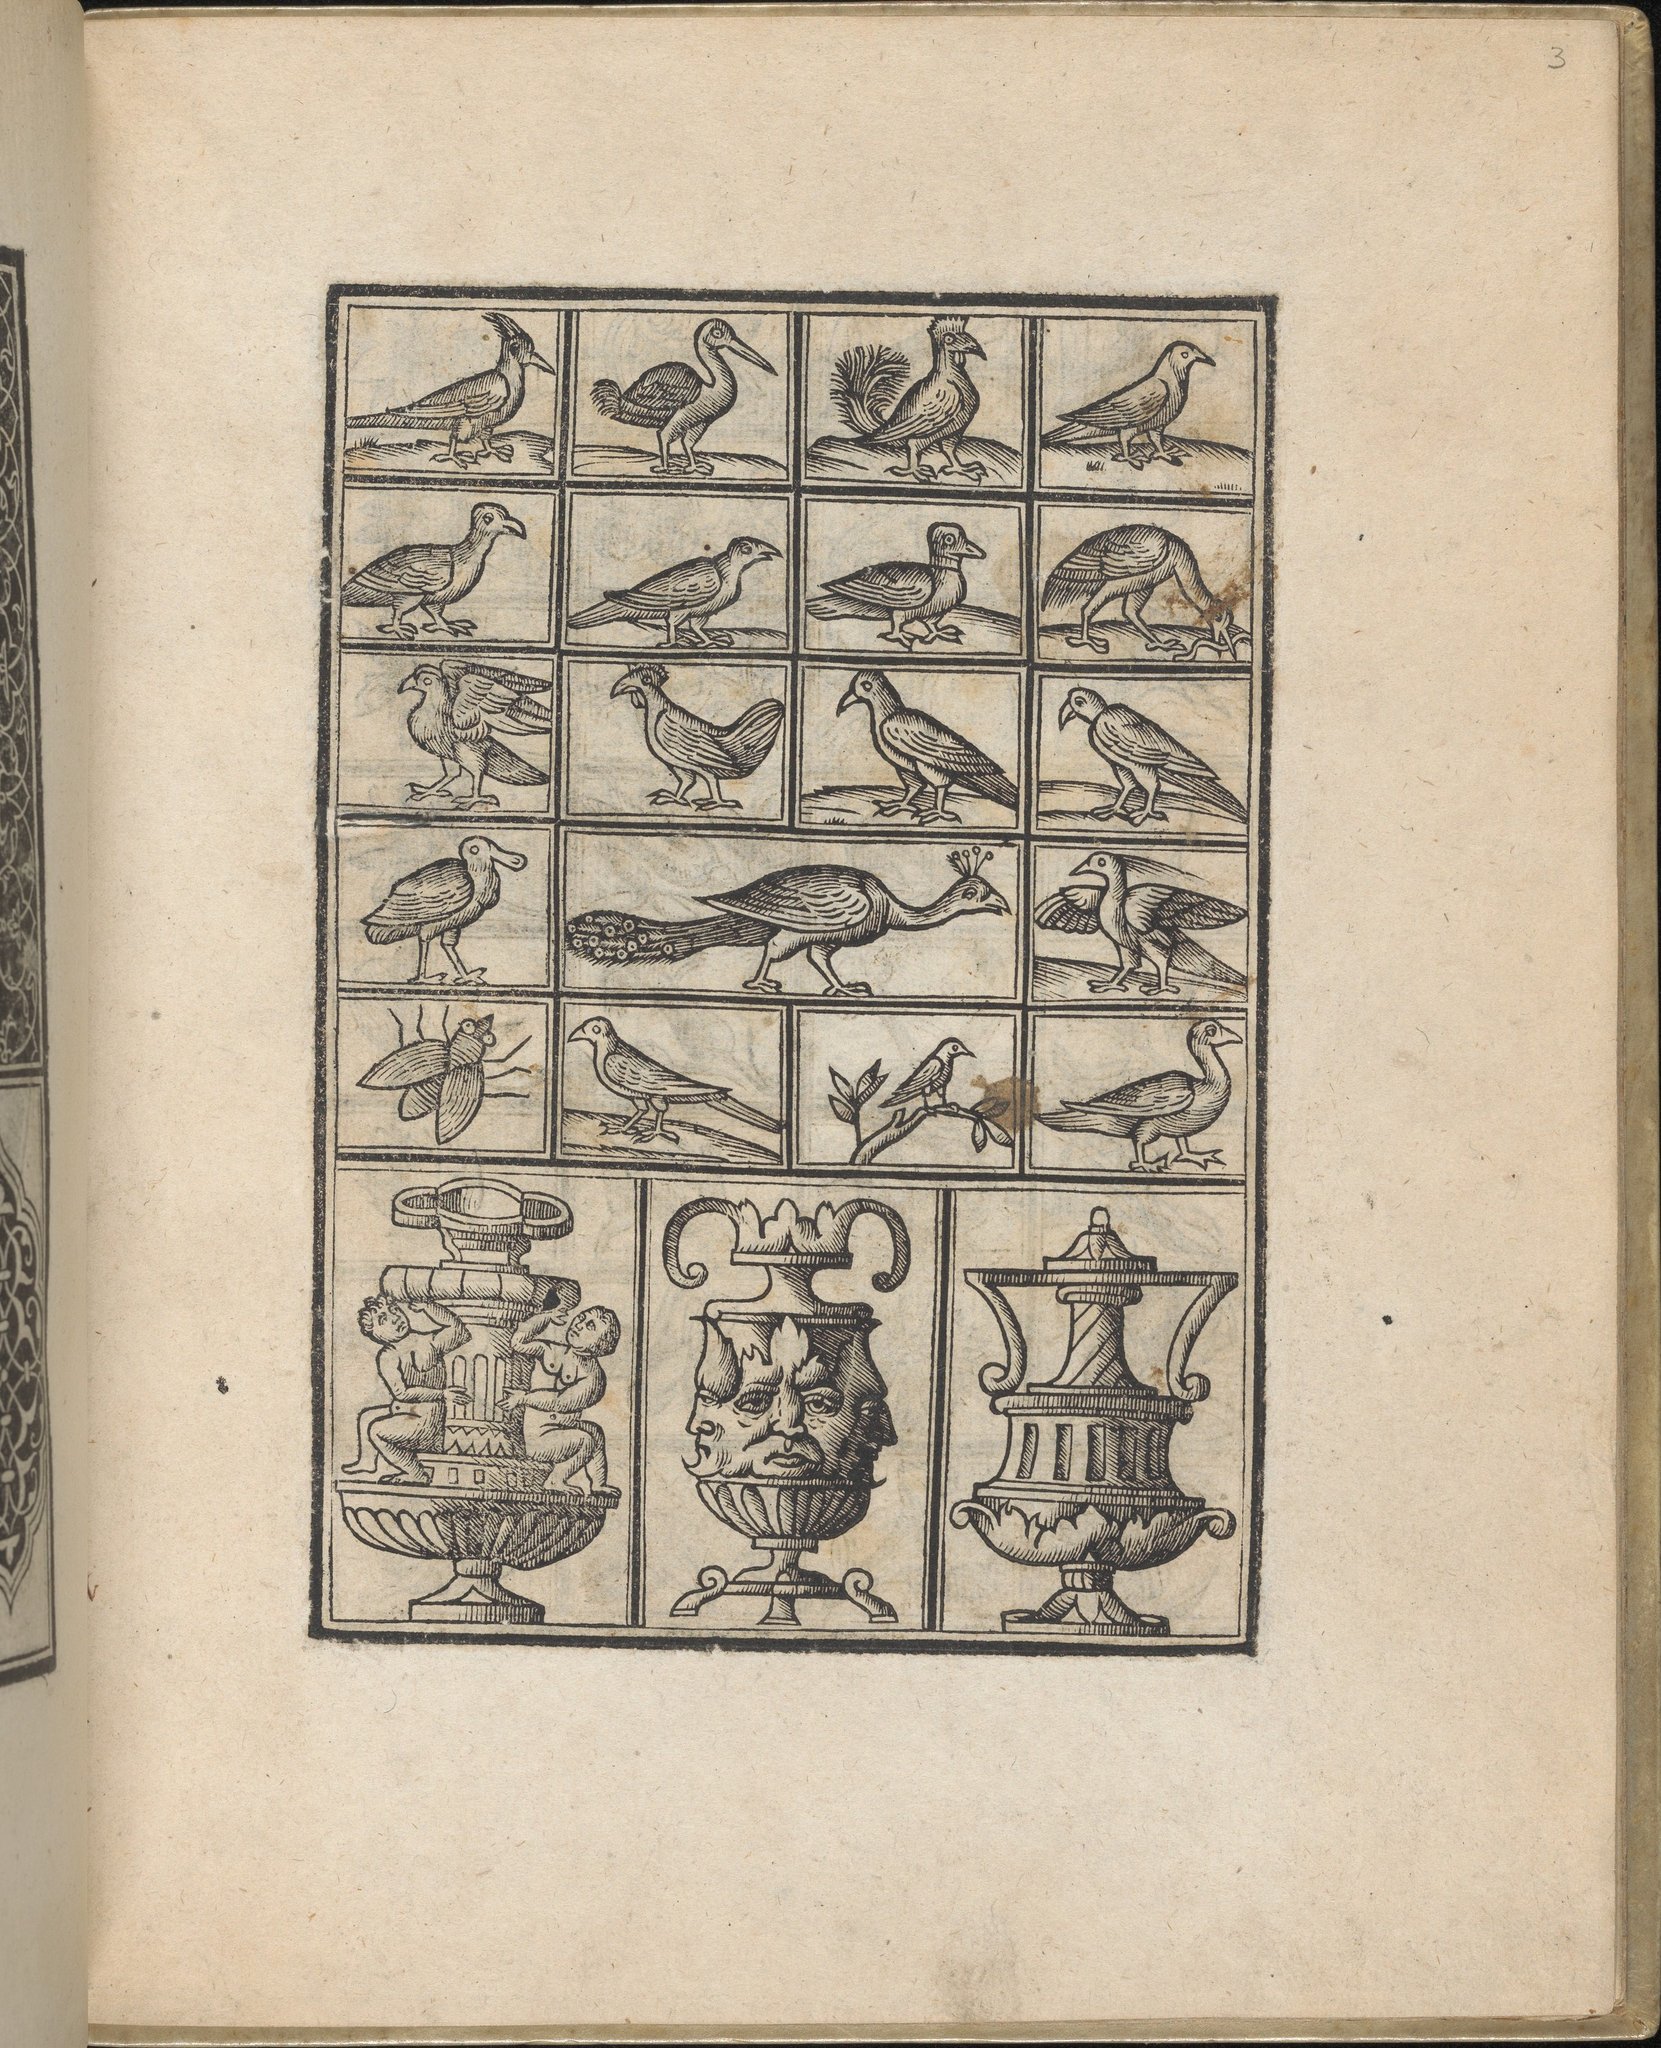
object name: book print ornament architecture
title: Trionfo Di Virtu. Libro Novo..., page 3 (recto)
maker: matteo pagano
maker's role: publisher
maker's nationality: italian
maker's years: 1515-1588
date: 1563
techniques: woodcut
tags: birds,peacocks,insects,vases